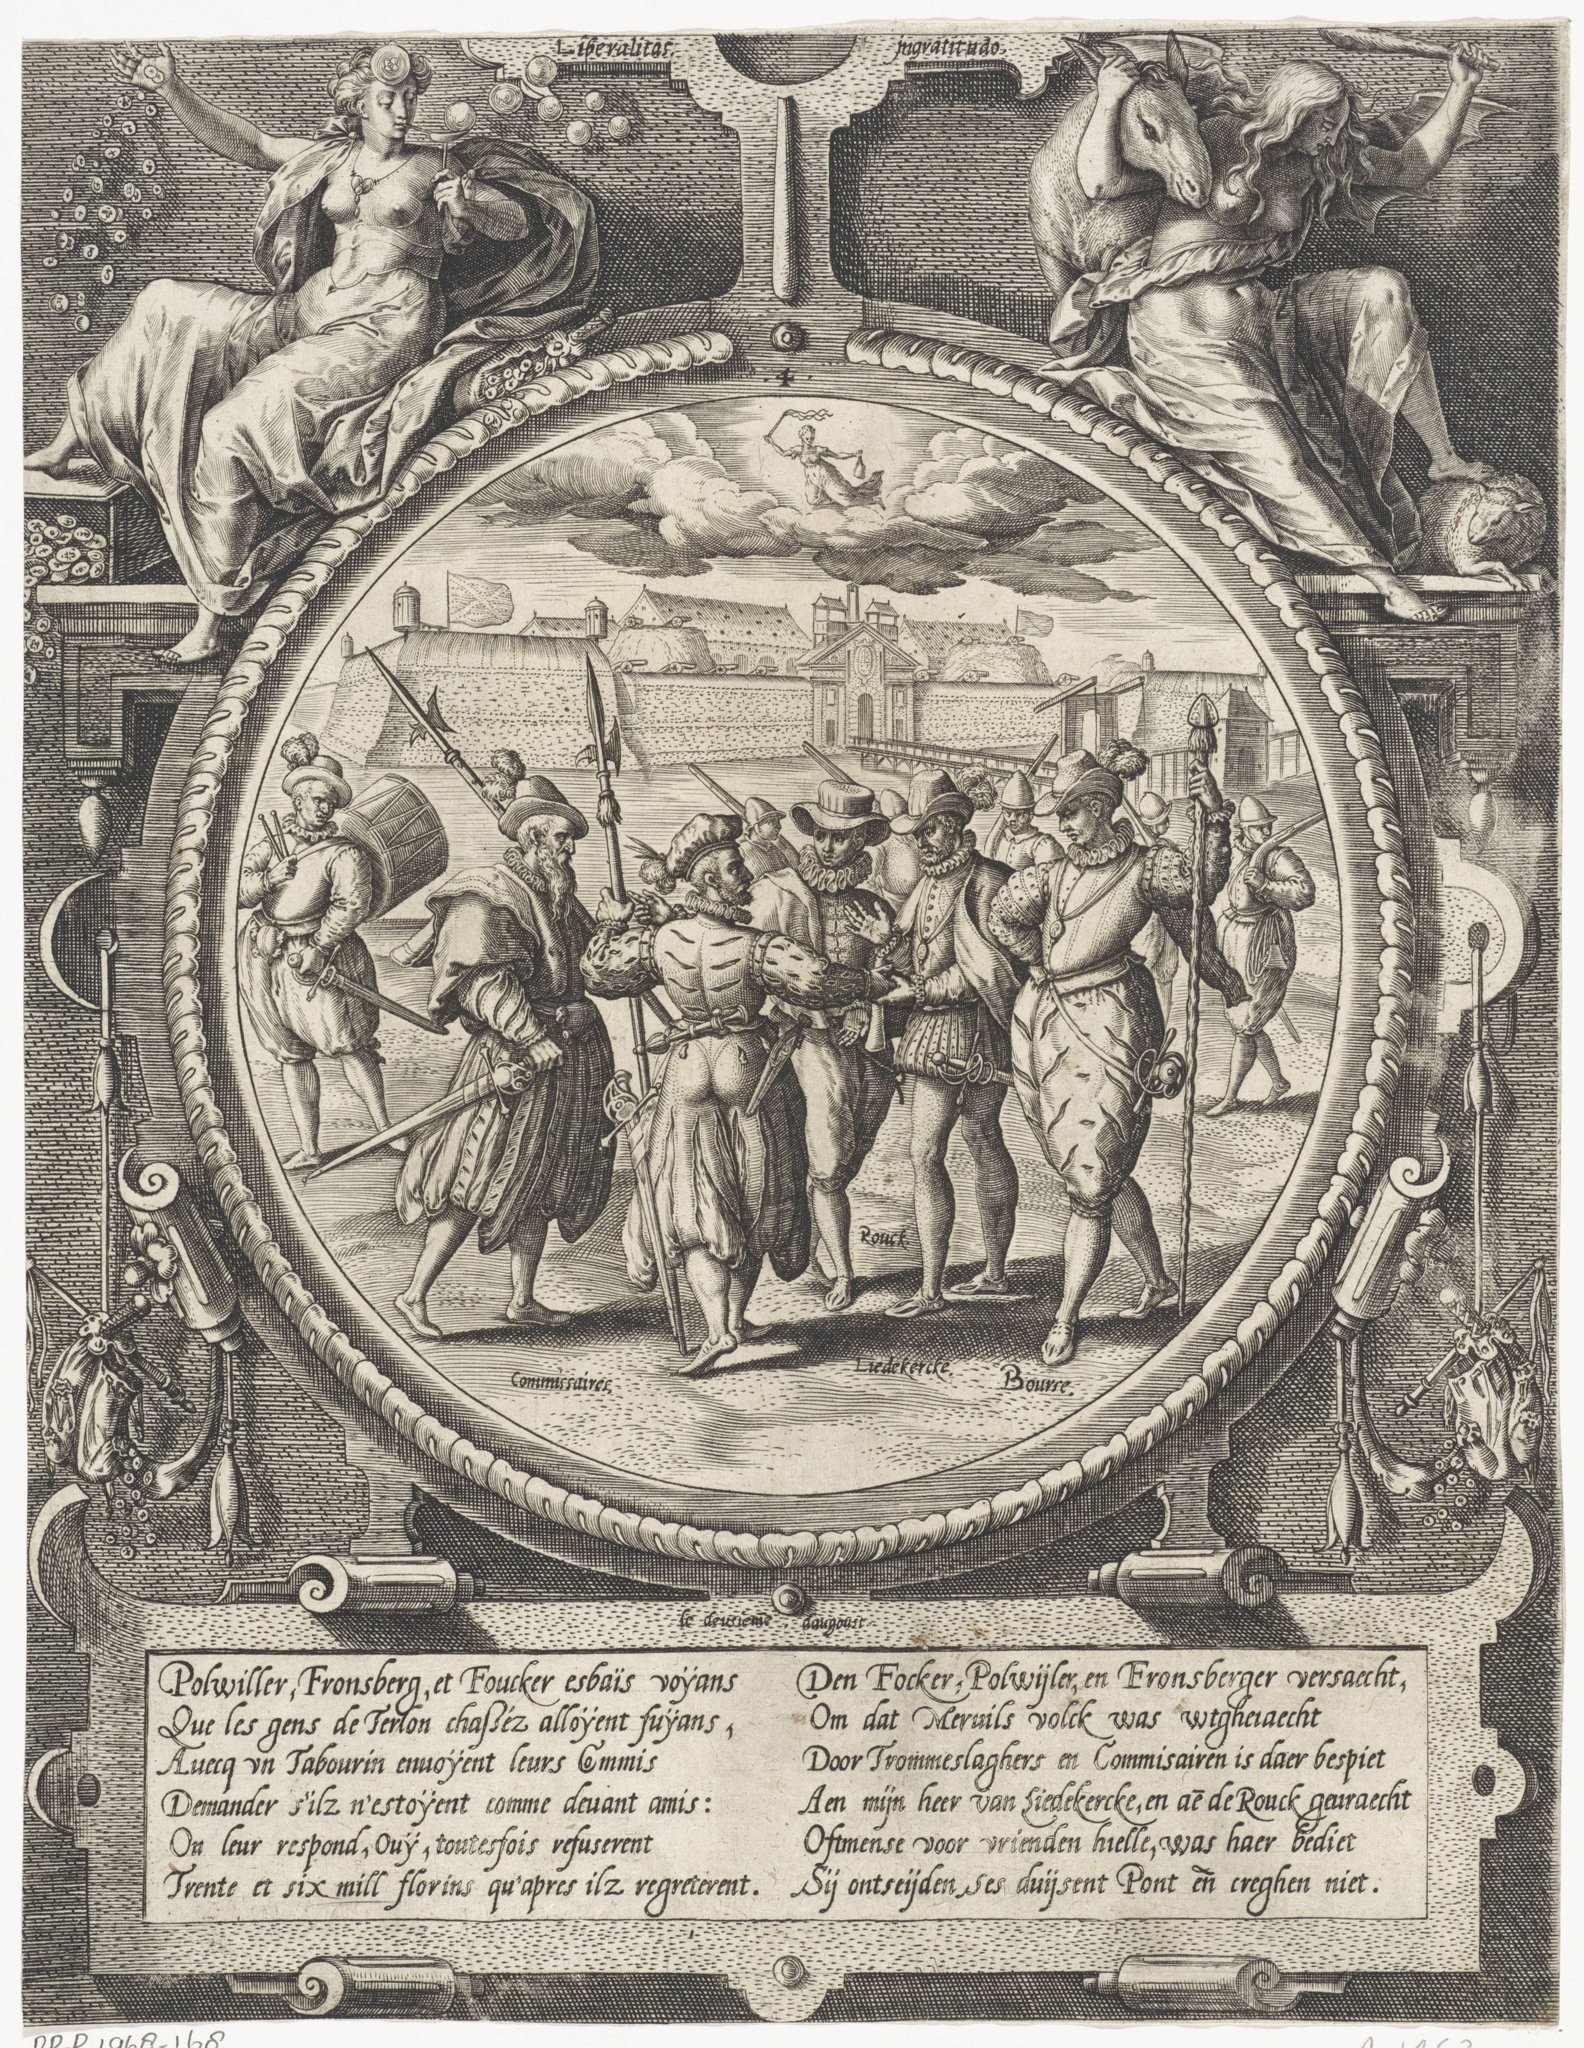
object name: propagandaprent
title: Medaillons met de verovering van de citadel van Antwerpen in 1577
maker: wierix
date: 1578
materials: paper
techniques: engraving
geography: antwerp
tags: negotiations for truce, ingratitude; 'ingratitudine' (ripa), generosity, liberality; 'generosità', 'liberalità' (ripa), punishment; 'castigo', 'pena', 'punitione' (ripa)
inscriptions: collector's mark: Lugt 2228, collector's mark: Lugt 2760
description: Onderhandelingen tussen Liedekercke, Roeck en Bourse en de Duitse commandanten over een afkoopsom voor het vertrek van het Duitse garnizoen, 2 augustus 1577. Groep mannen staande in overleg, op de achtergrond de citadel. In de wolken de personificatie van Gods bestraffing. Voorstelling in een rond medaillon met ornamentale allegorische omlijsting met bovenaan de zittende vrouwelijke personificaties van Vrijgevigheid (Liberalitas) en Ondankbaarheid (Ingratitudo). Onderaan een cartouche met 2 verzen van elk 6 regels in het Frans en Nederlands.